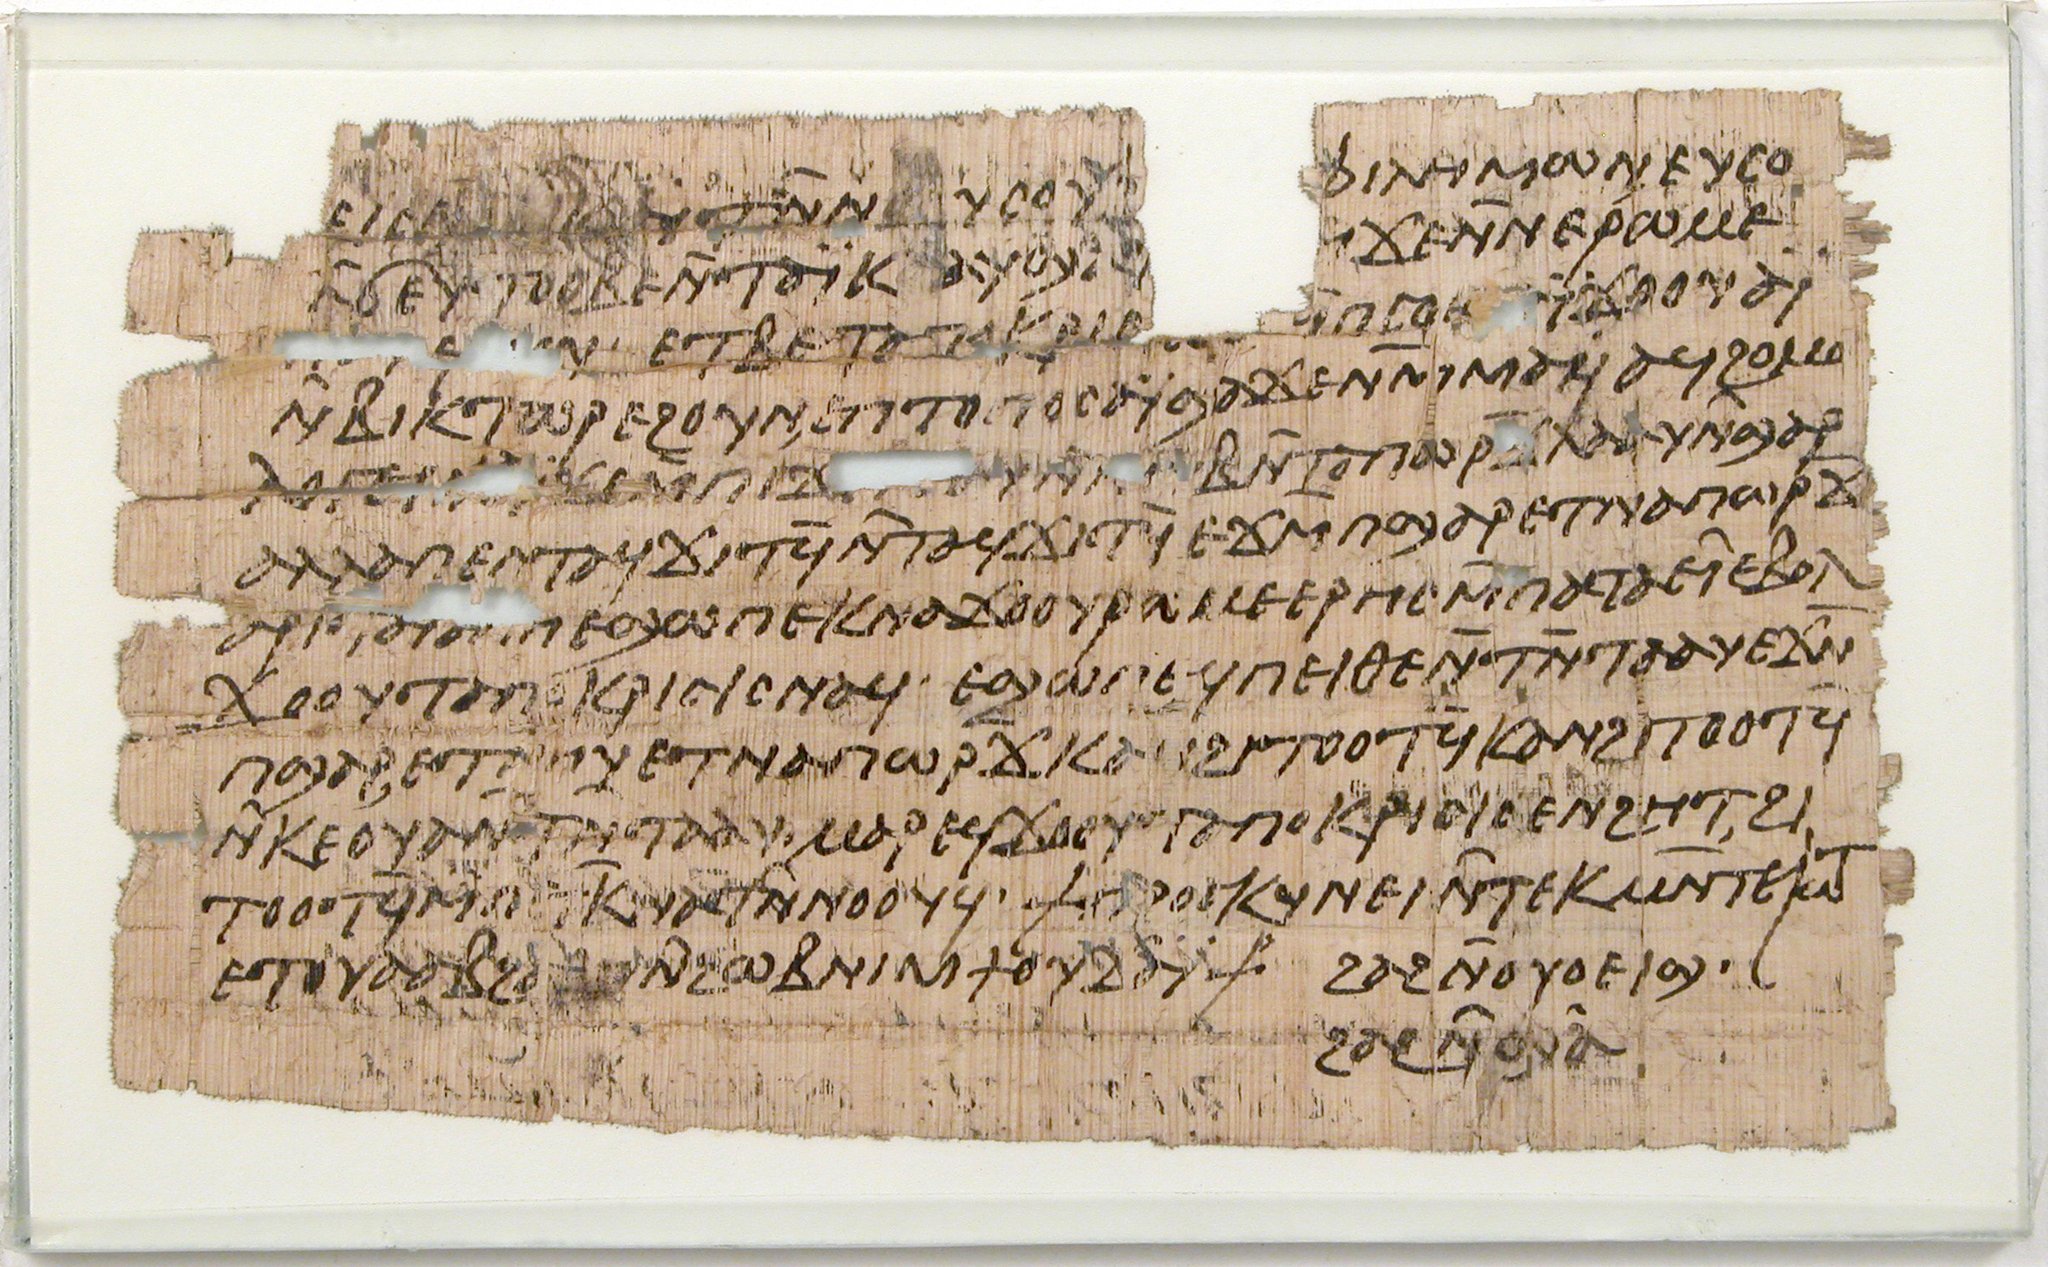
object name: fragment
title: Papyrus Fragment from a Psalter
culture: coptic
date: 601-700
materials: ink, papyrus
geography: egypt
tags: coptic,documents